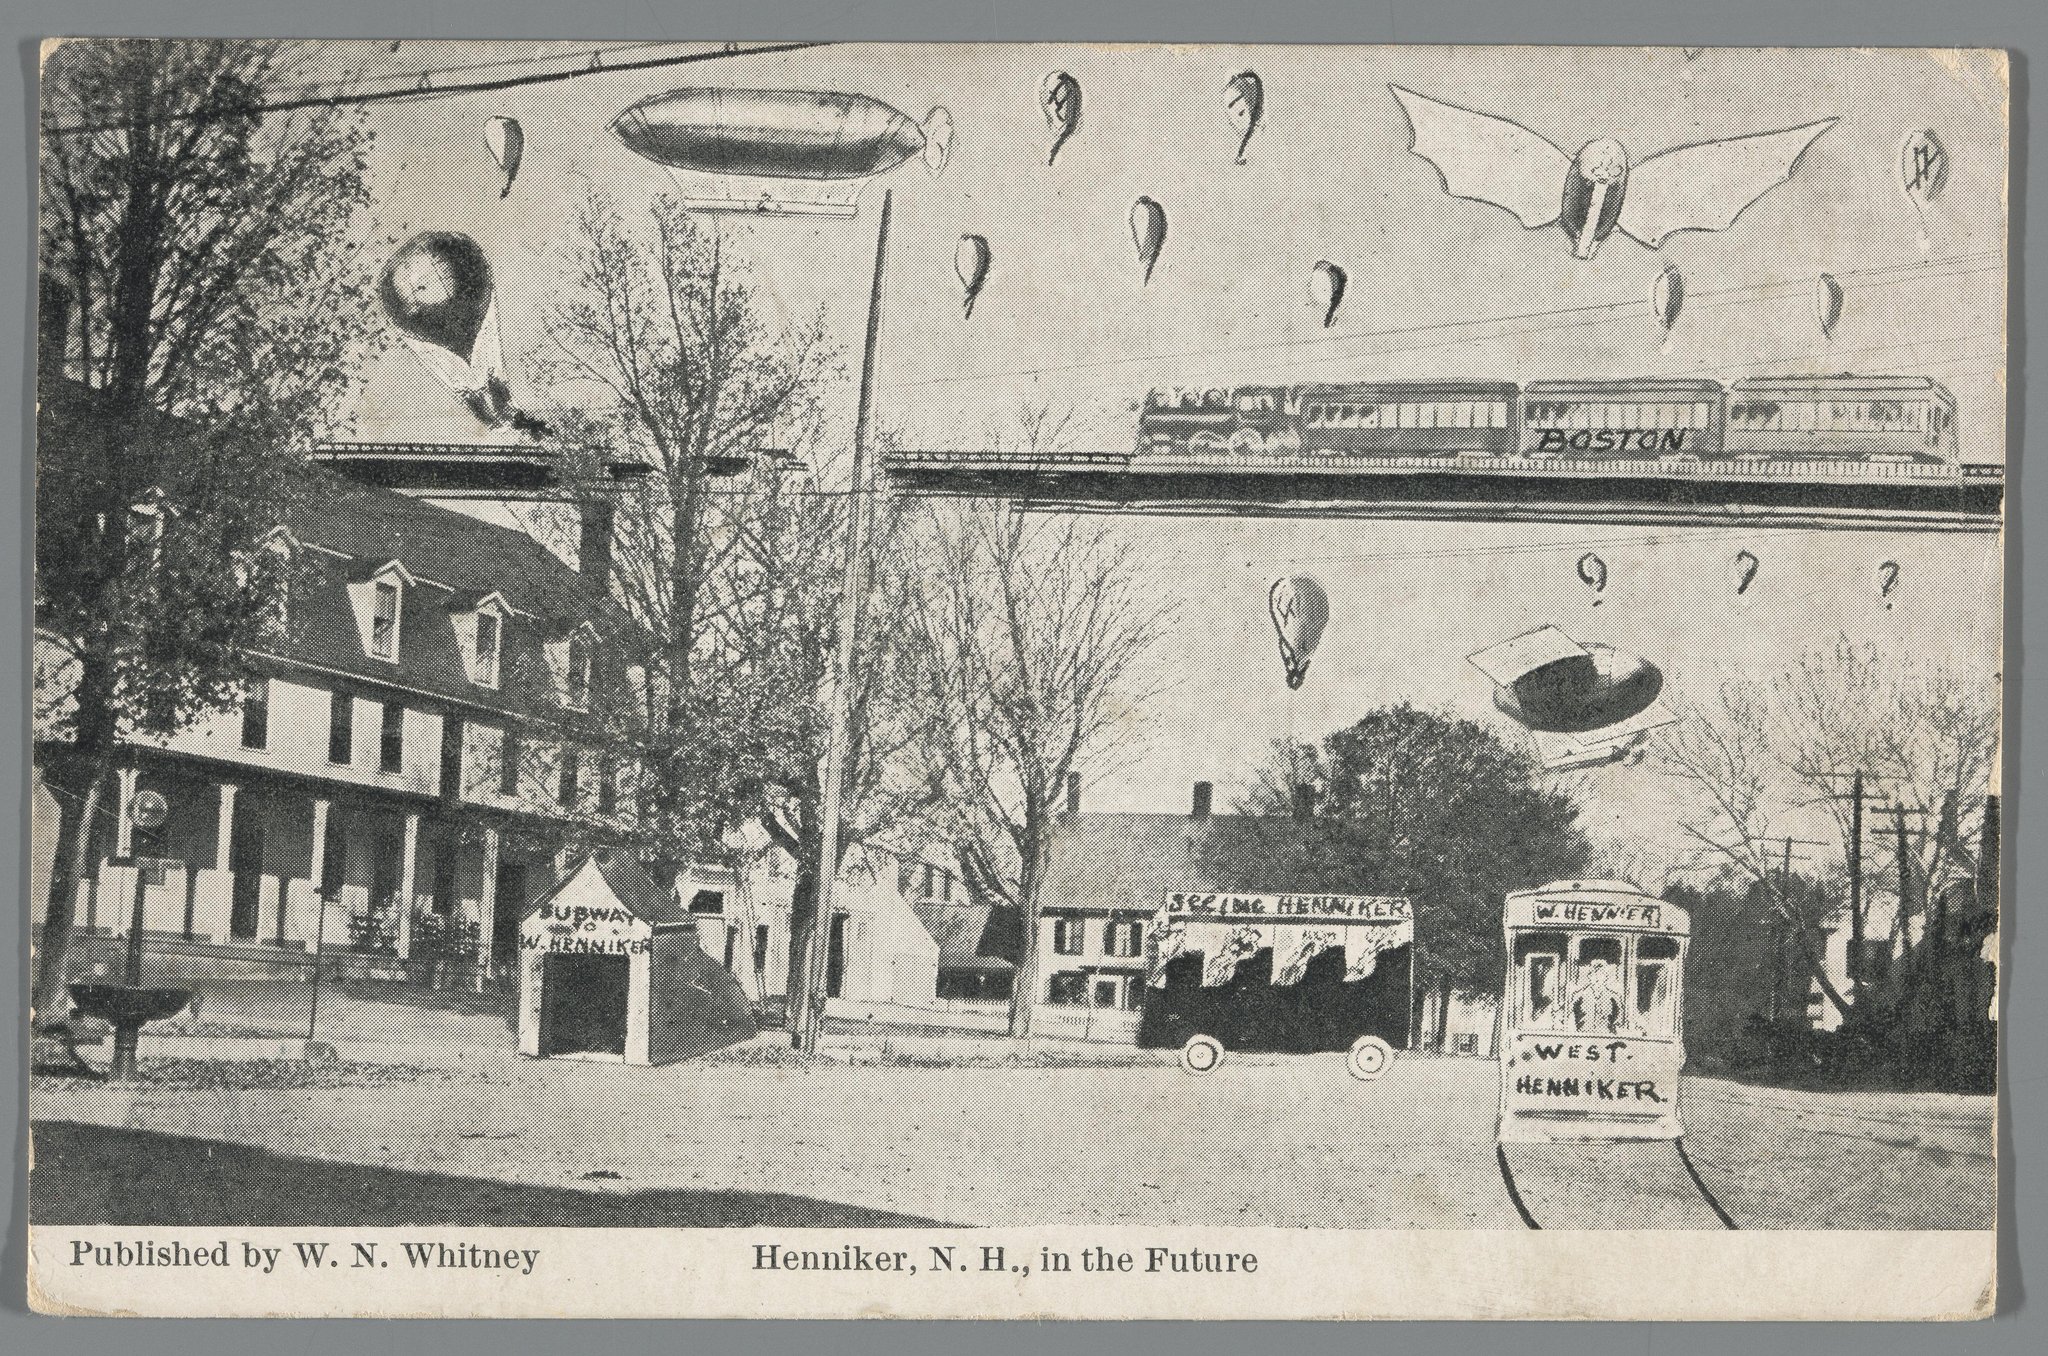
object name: ansichtkaart, prentbriefkaart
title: City of the Future (Henniker, NH)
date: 1910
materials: cardboard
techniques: collage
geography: united states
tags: henniker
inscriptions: inscription: ‘aug 13-1911 / Show your Mama / how easy it will be / to go to Henniker – ask / her to bring you up here / when the cars are running / as shown on other side / […]’, : ‘1911’, inscription: ‘Published by W.N. Whitney / Henniker, N.H., in the Future’